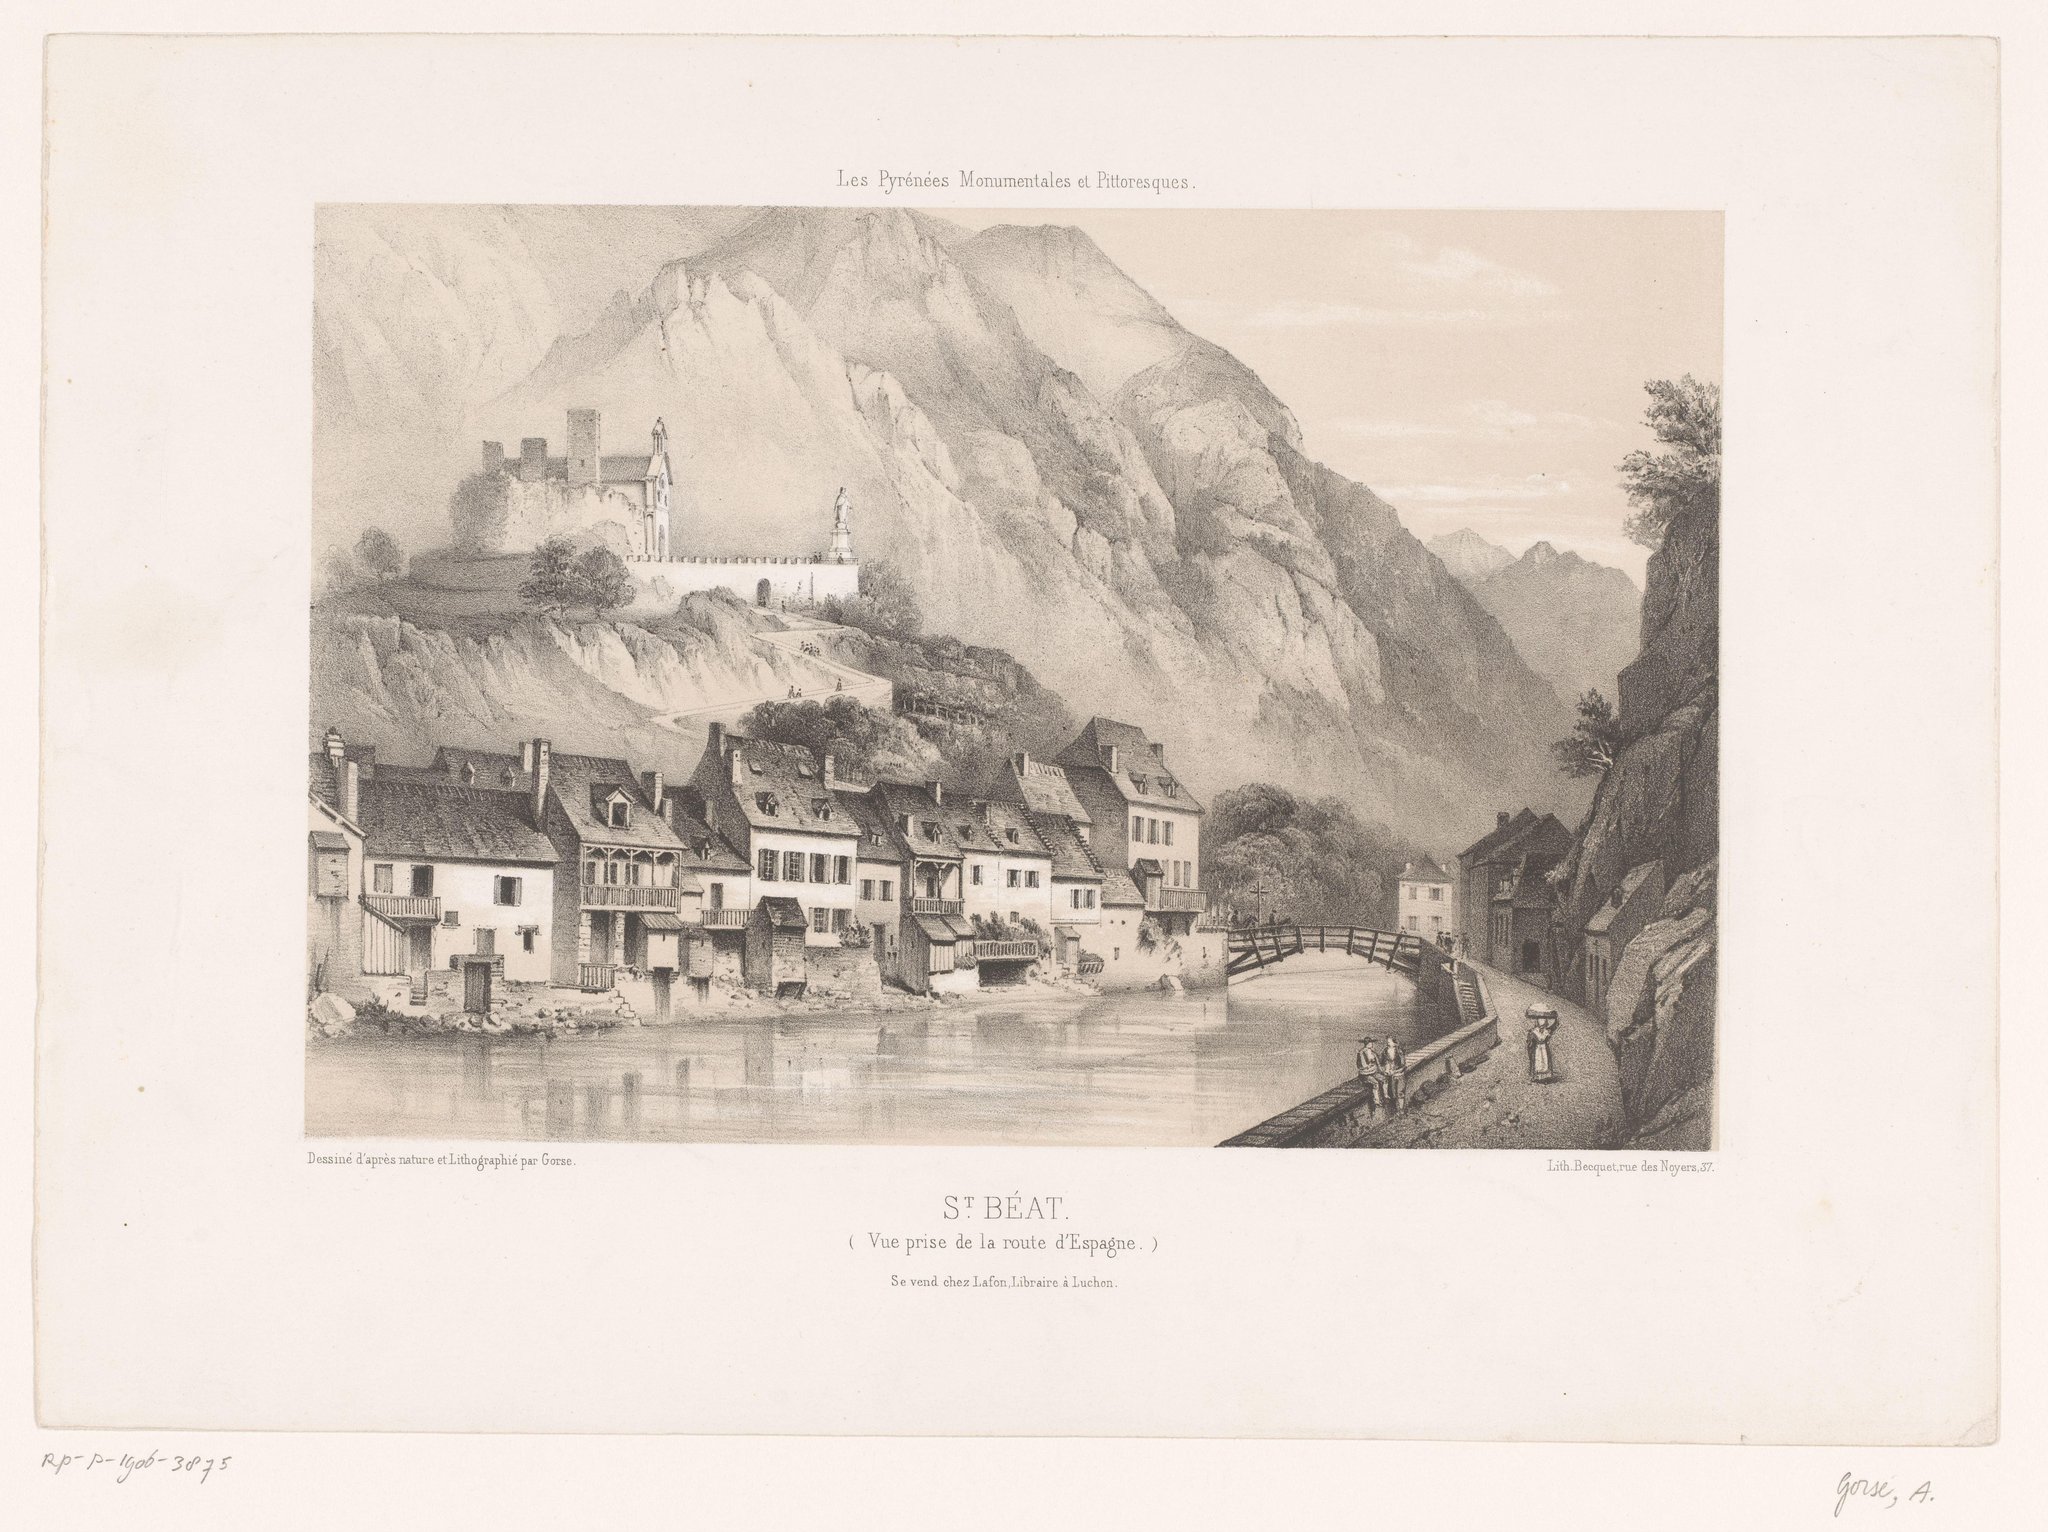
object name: print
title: Les Pyrénées Monumentales et Pittoresques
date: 1855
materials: paper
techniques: tone lithography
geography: luchon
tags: mountains (+ landscape with figures, staffage), river (+ landscape with figures, staffage), village (+ city(-scape) with figures, staffage), landscape with tower or castle (+ city(-scape) with figures, staffage)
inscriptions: collector's mark: Lugt 2228a